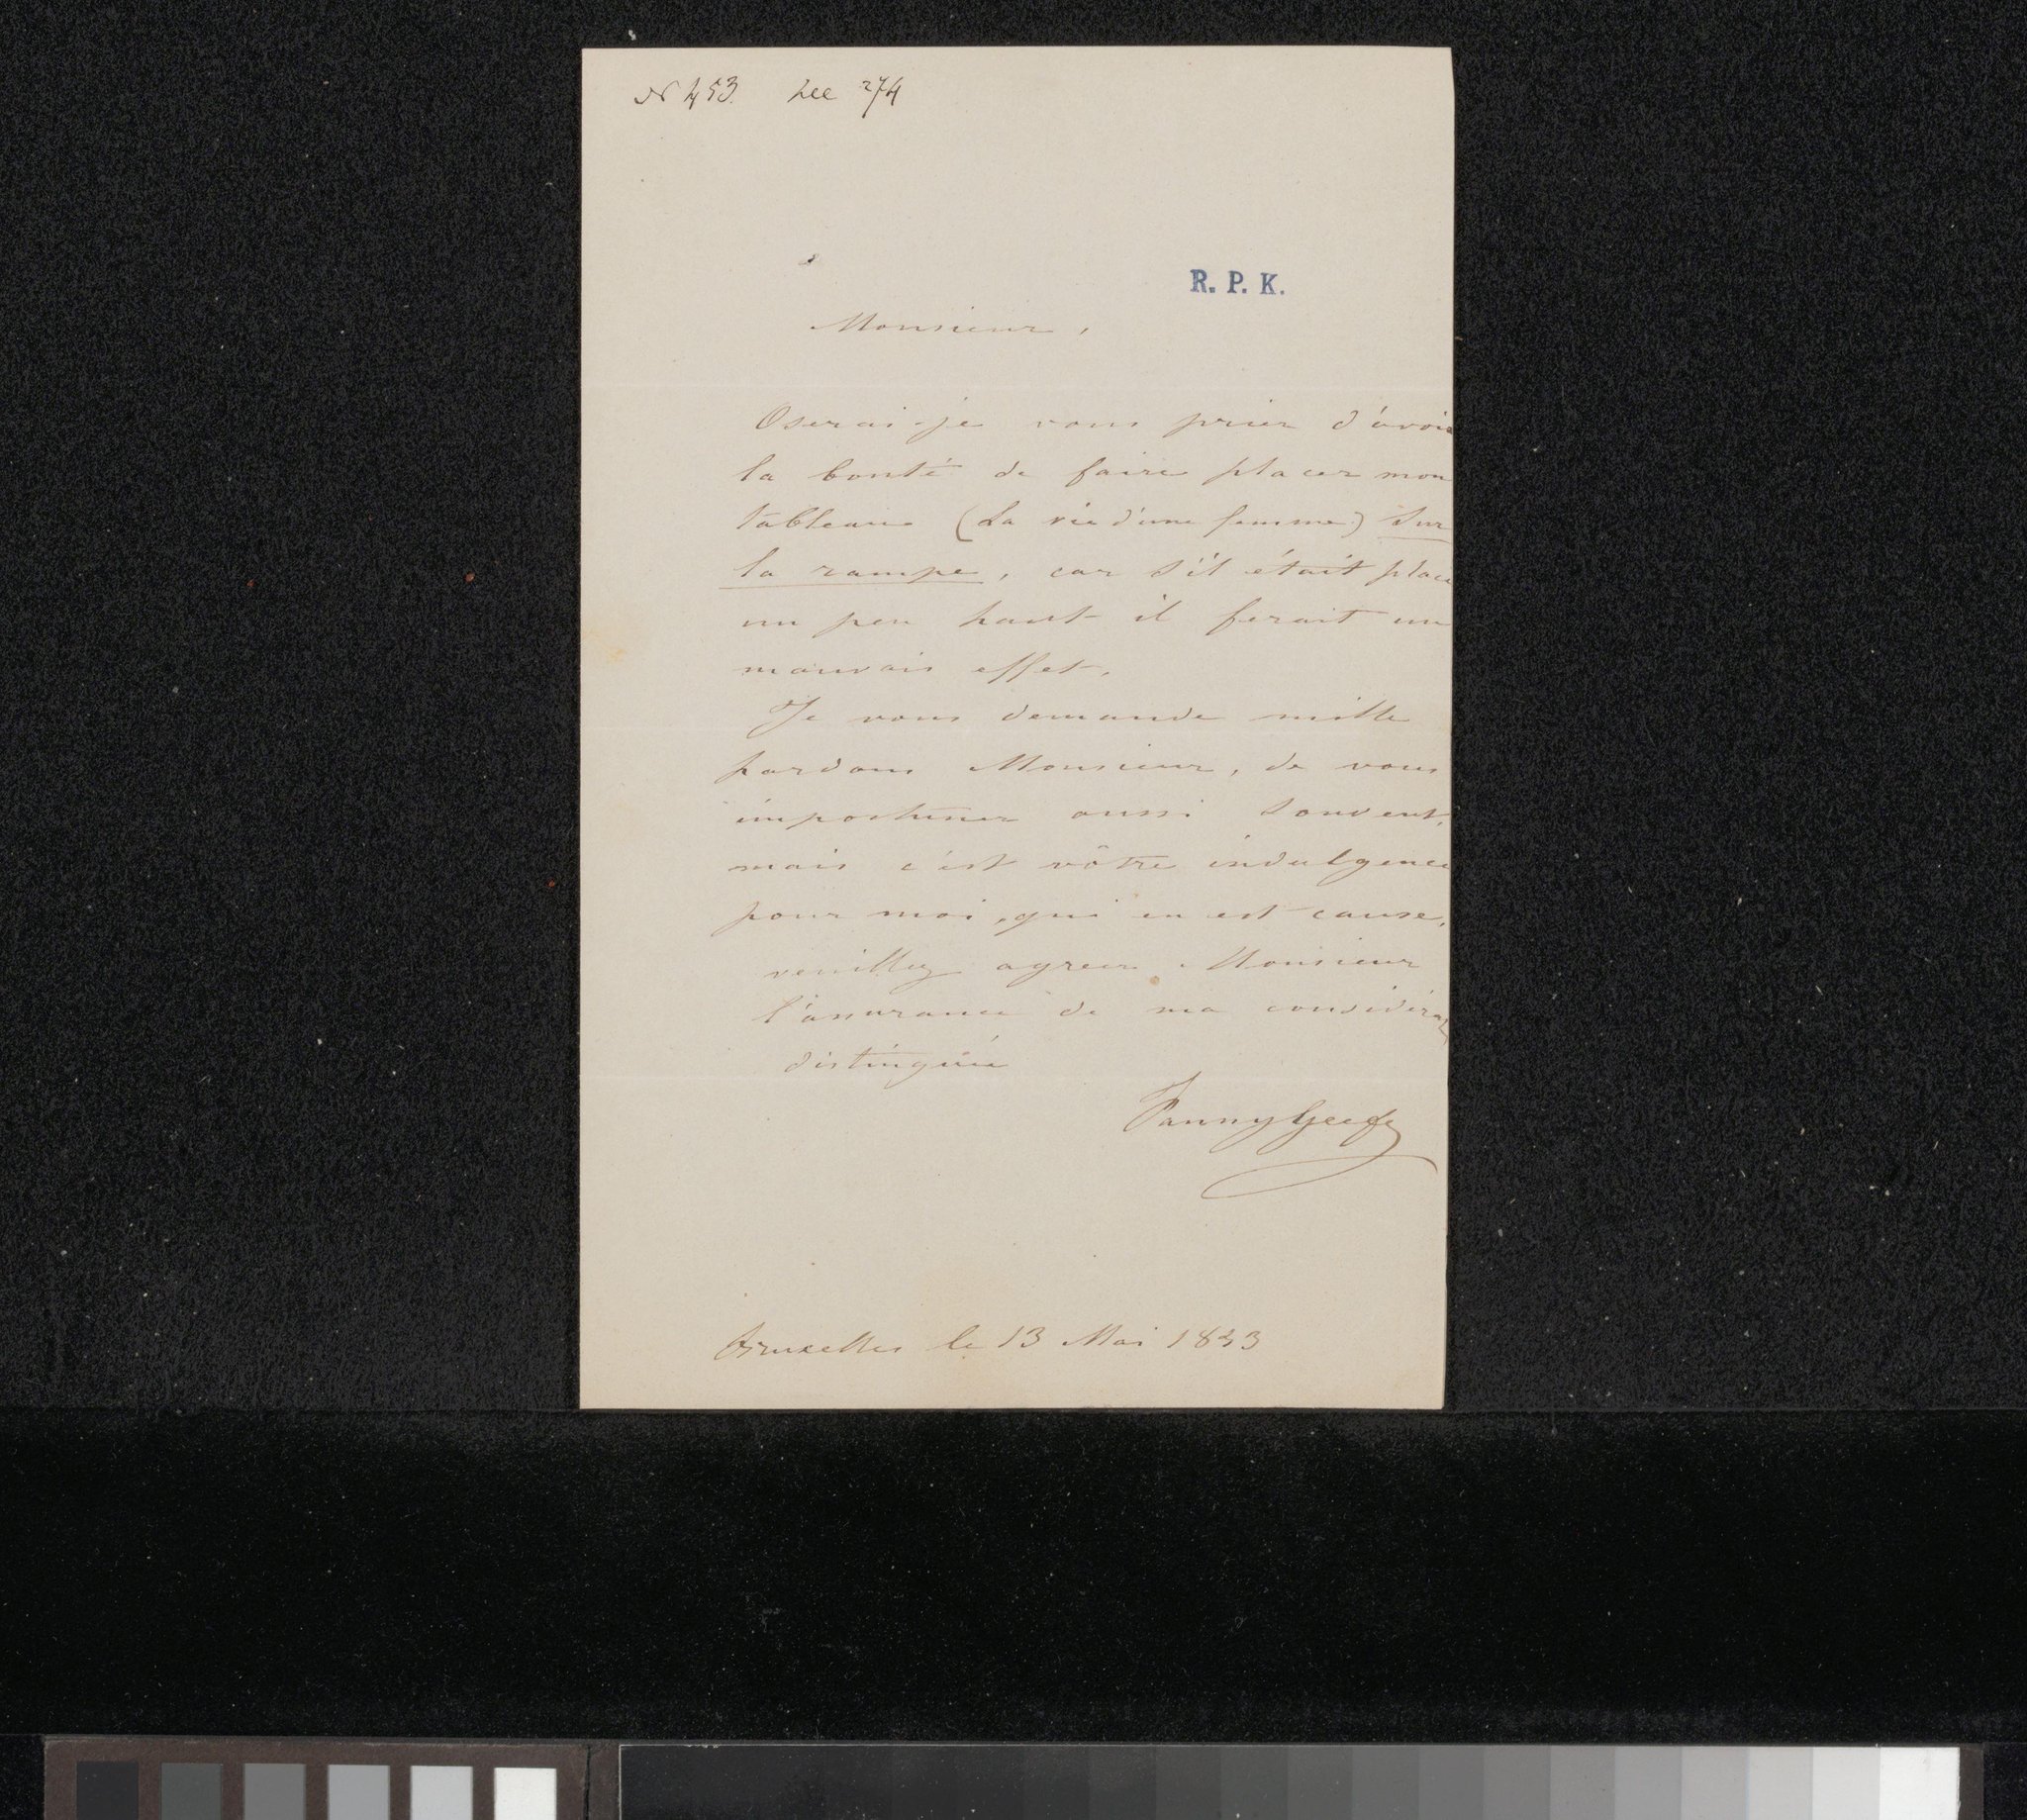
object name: letter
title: Brief aan anoniem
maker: fanny geefs-corr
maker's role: draughtsman, painter, print maker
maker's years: 1807-1883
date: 1843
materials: ink, paper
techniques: pen, writing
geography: brussels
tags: painting (including book-illumination, miniature-painting), exhibition ~ art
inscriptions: collector's mark: Lugt 2233